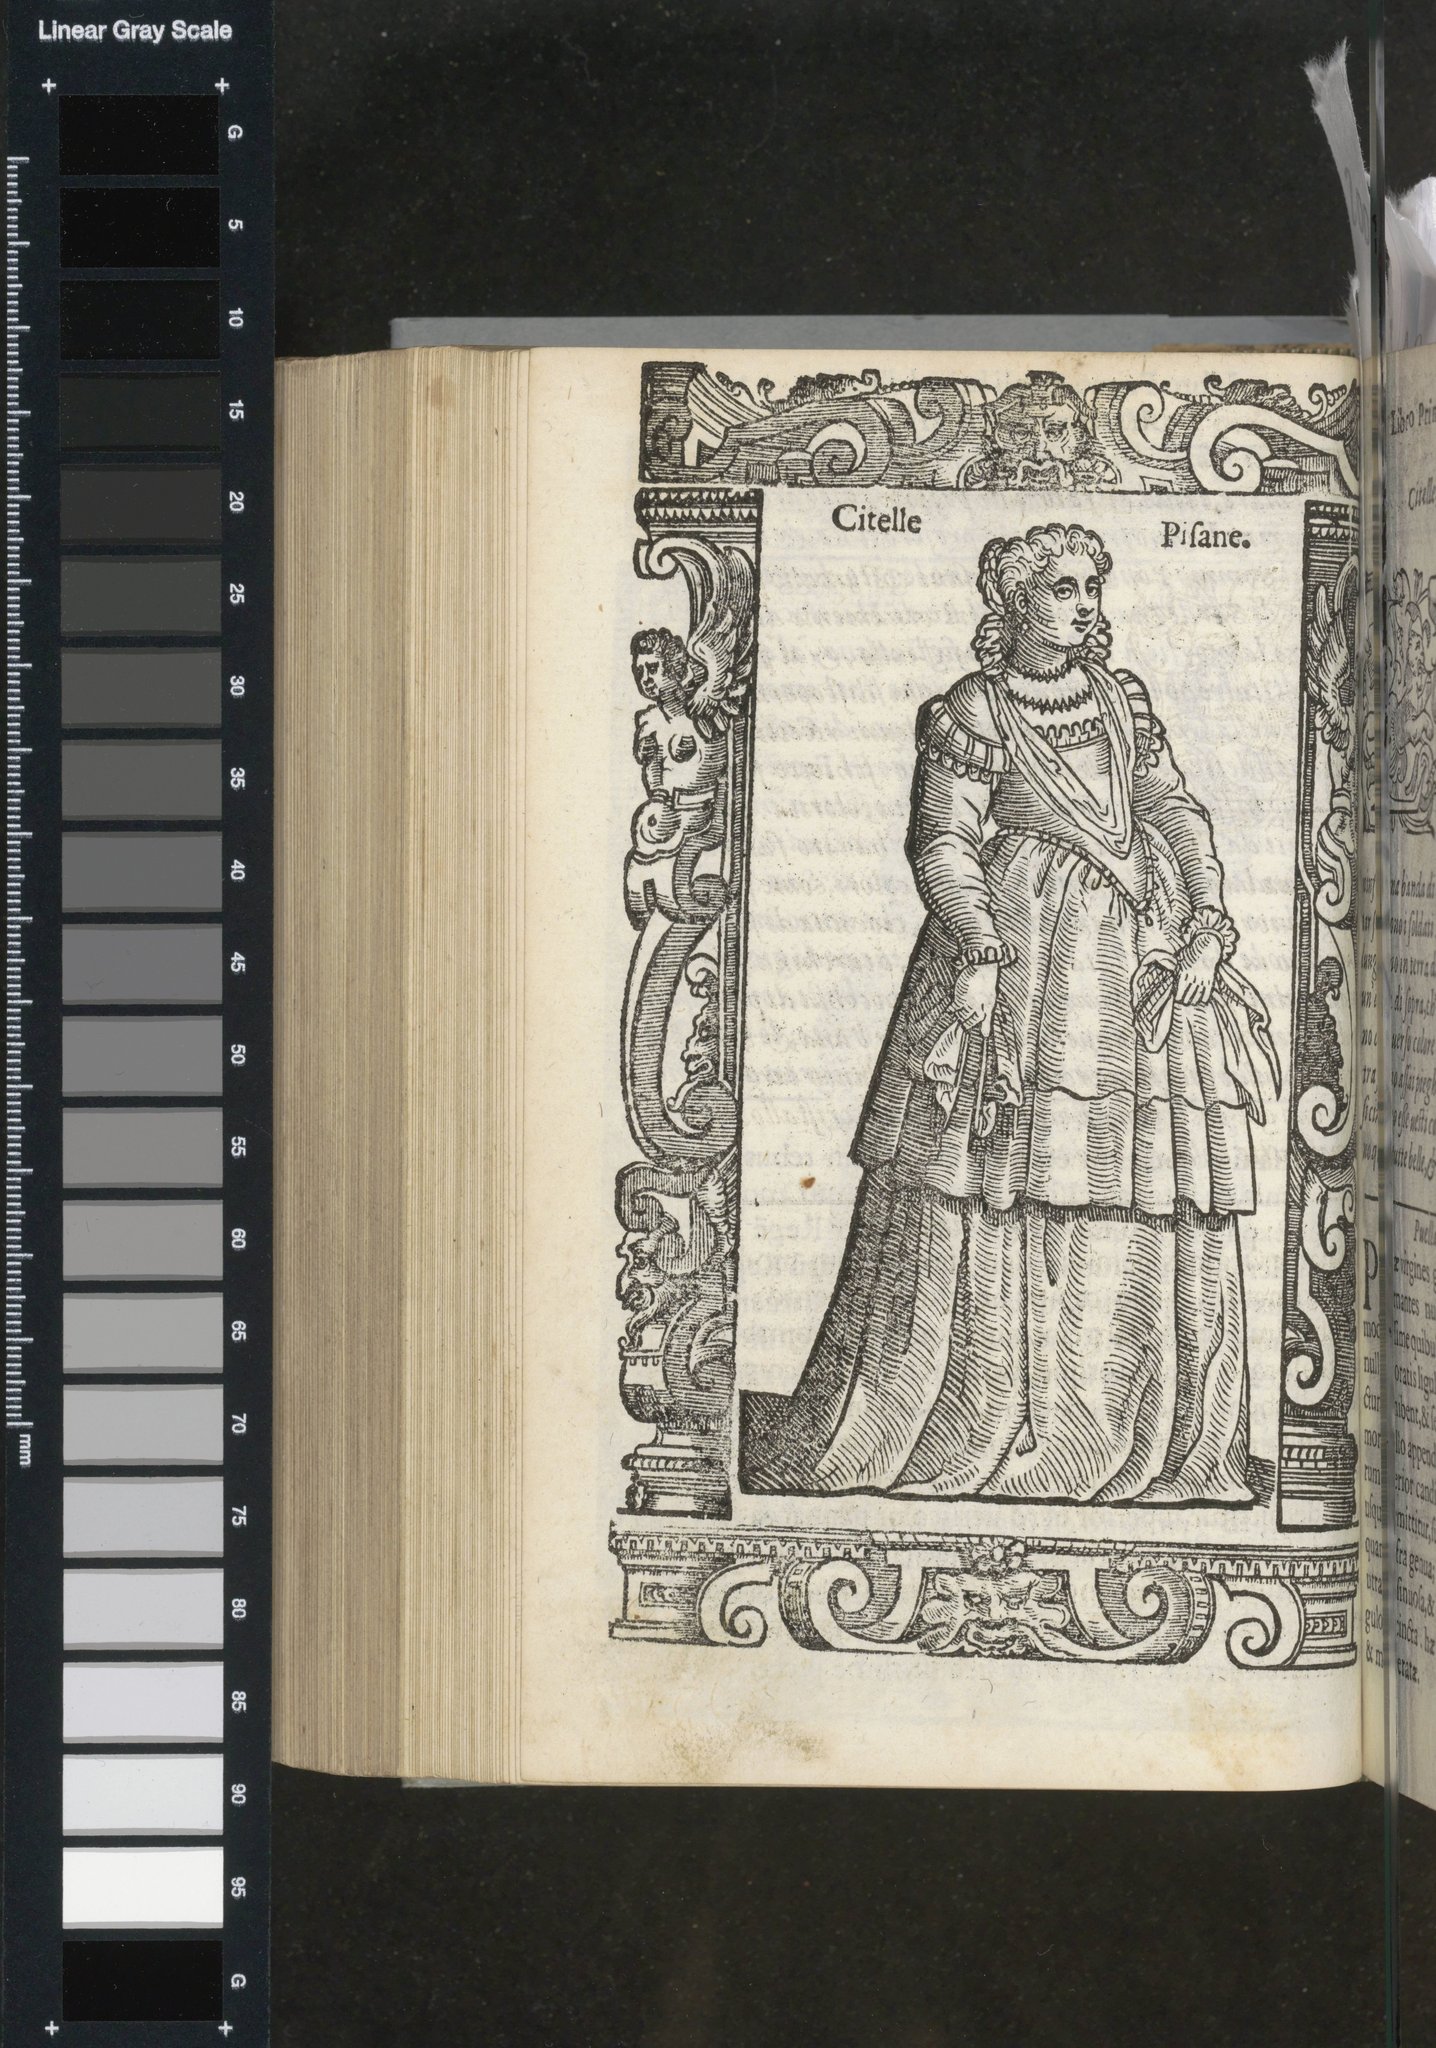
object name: costume print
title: Citenne Pisane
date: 1598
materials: paper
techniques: woodcut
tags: fashion plates